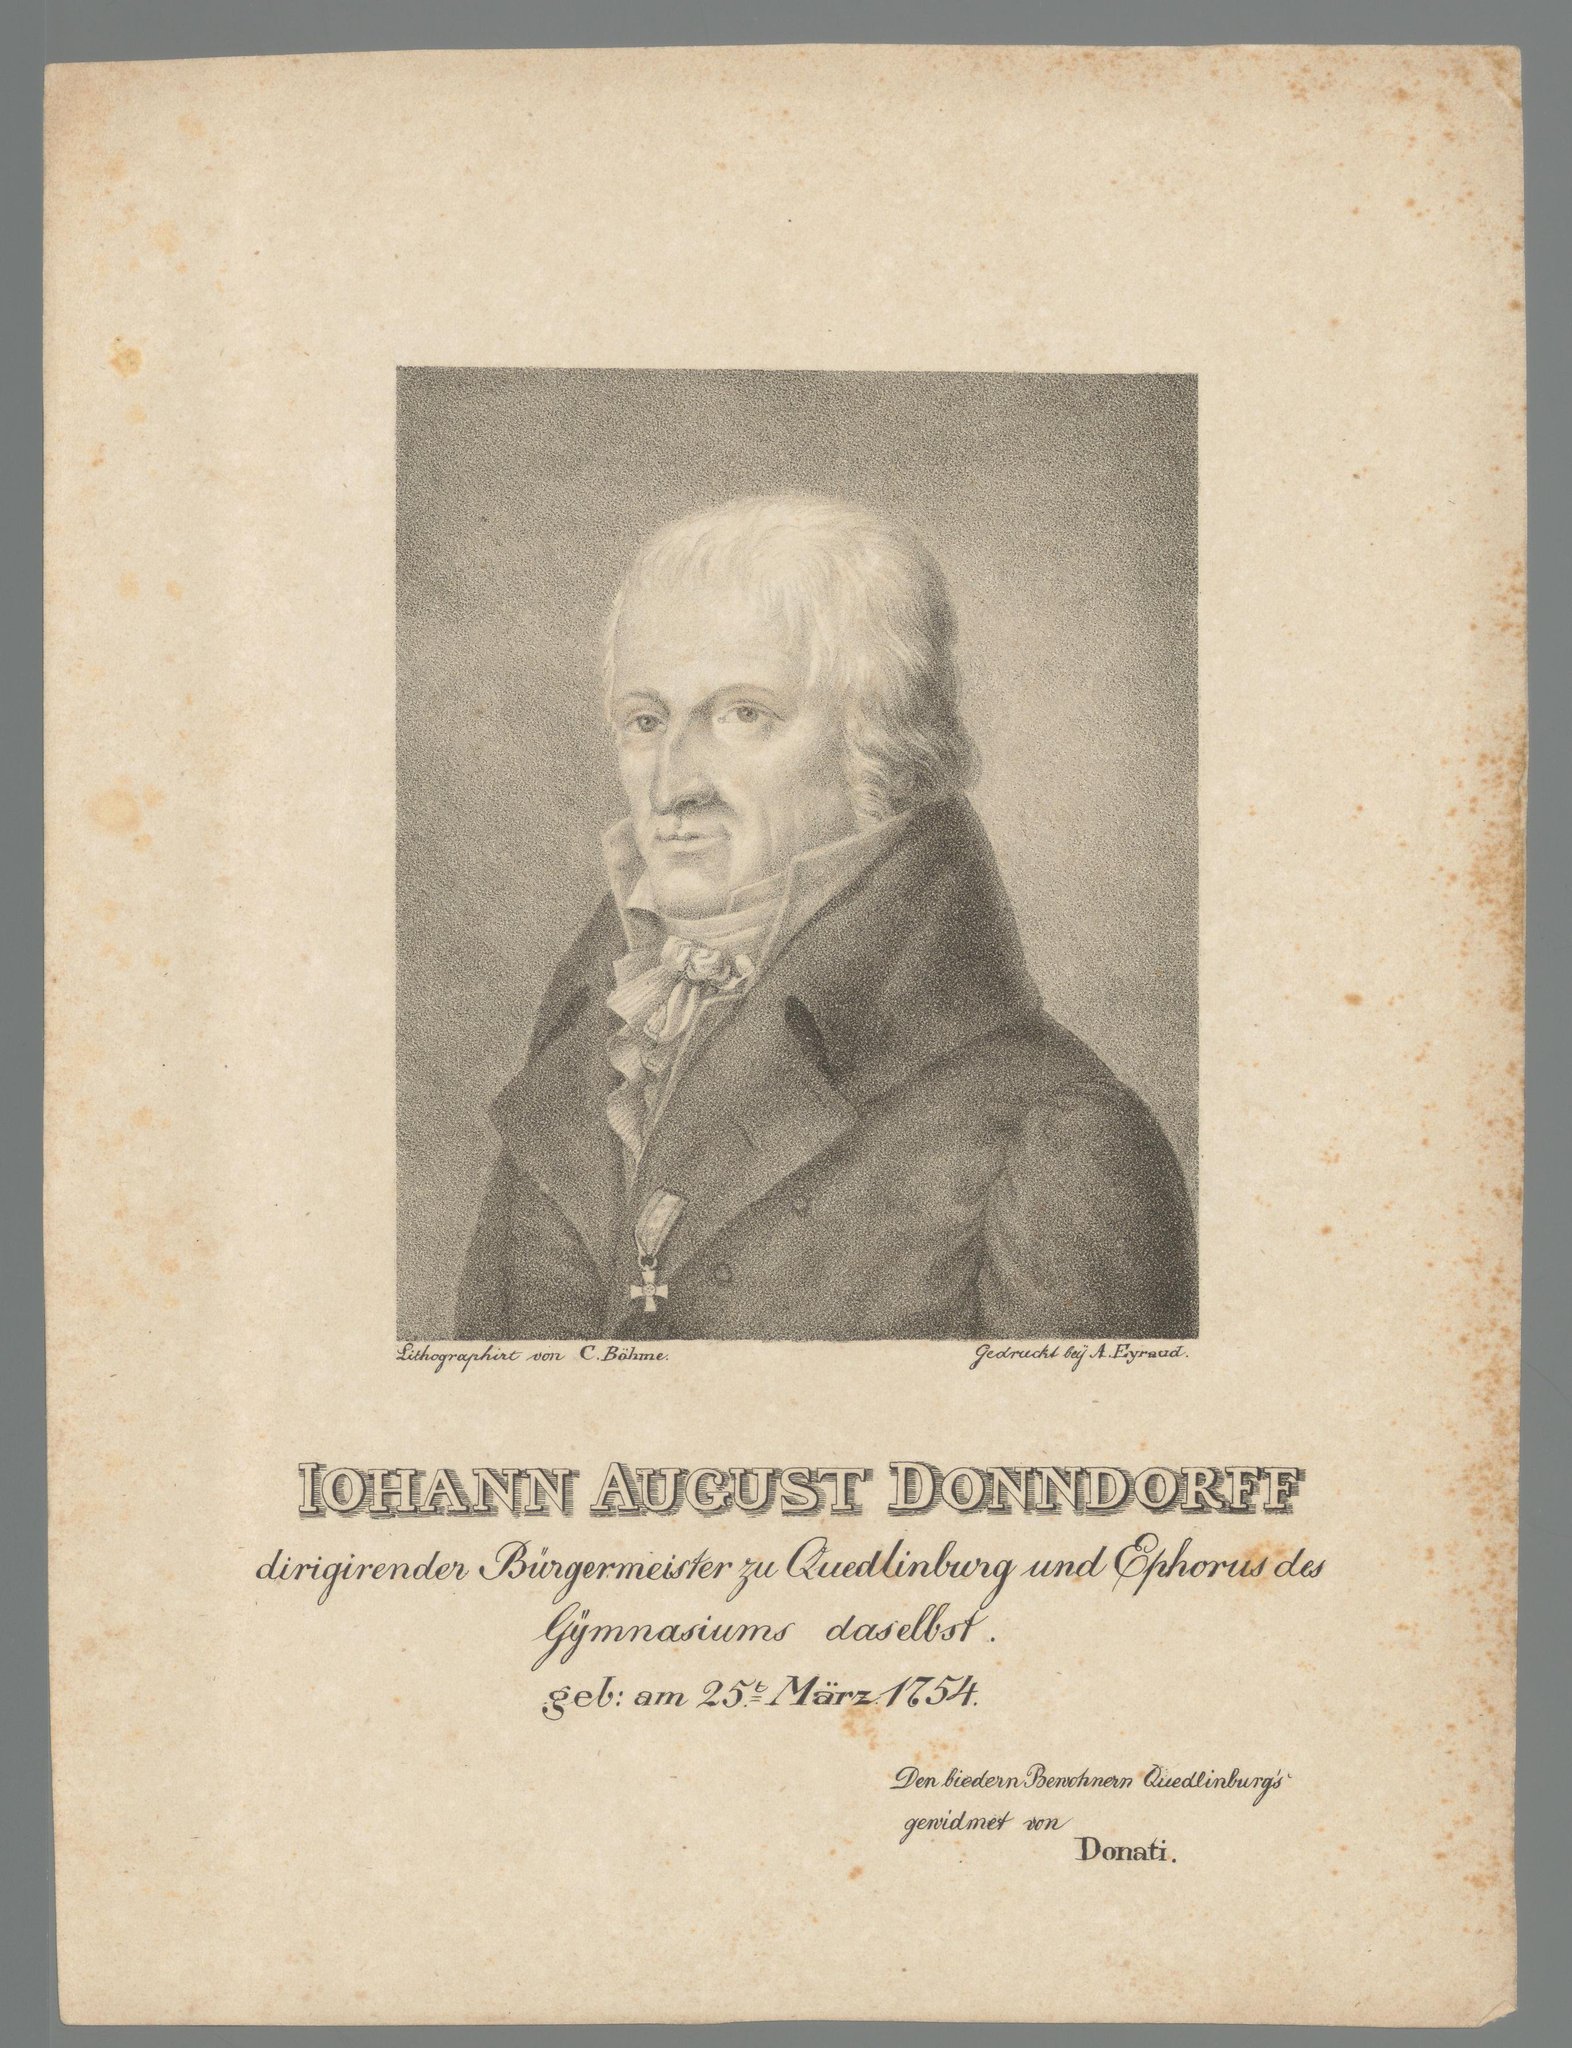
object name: print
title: Portret van Johann August Donndorff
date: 1825-1874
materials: paper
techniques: lithograph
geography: quedlinburg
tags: adult man, historical persons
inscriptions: collector's mark: Lugt 2228